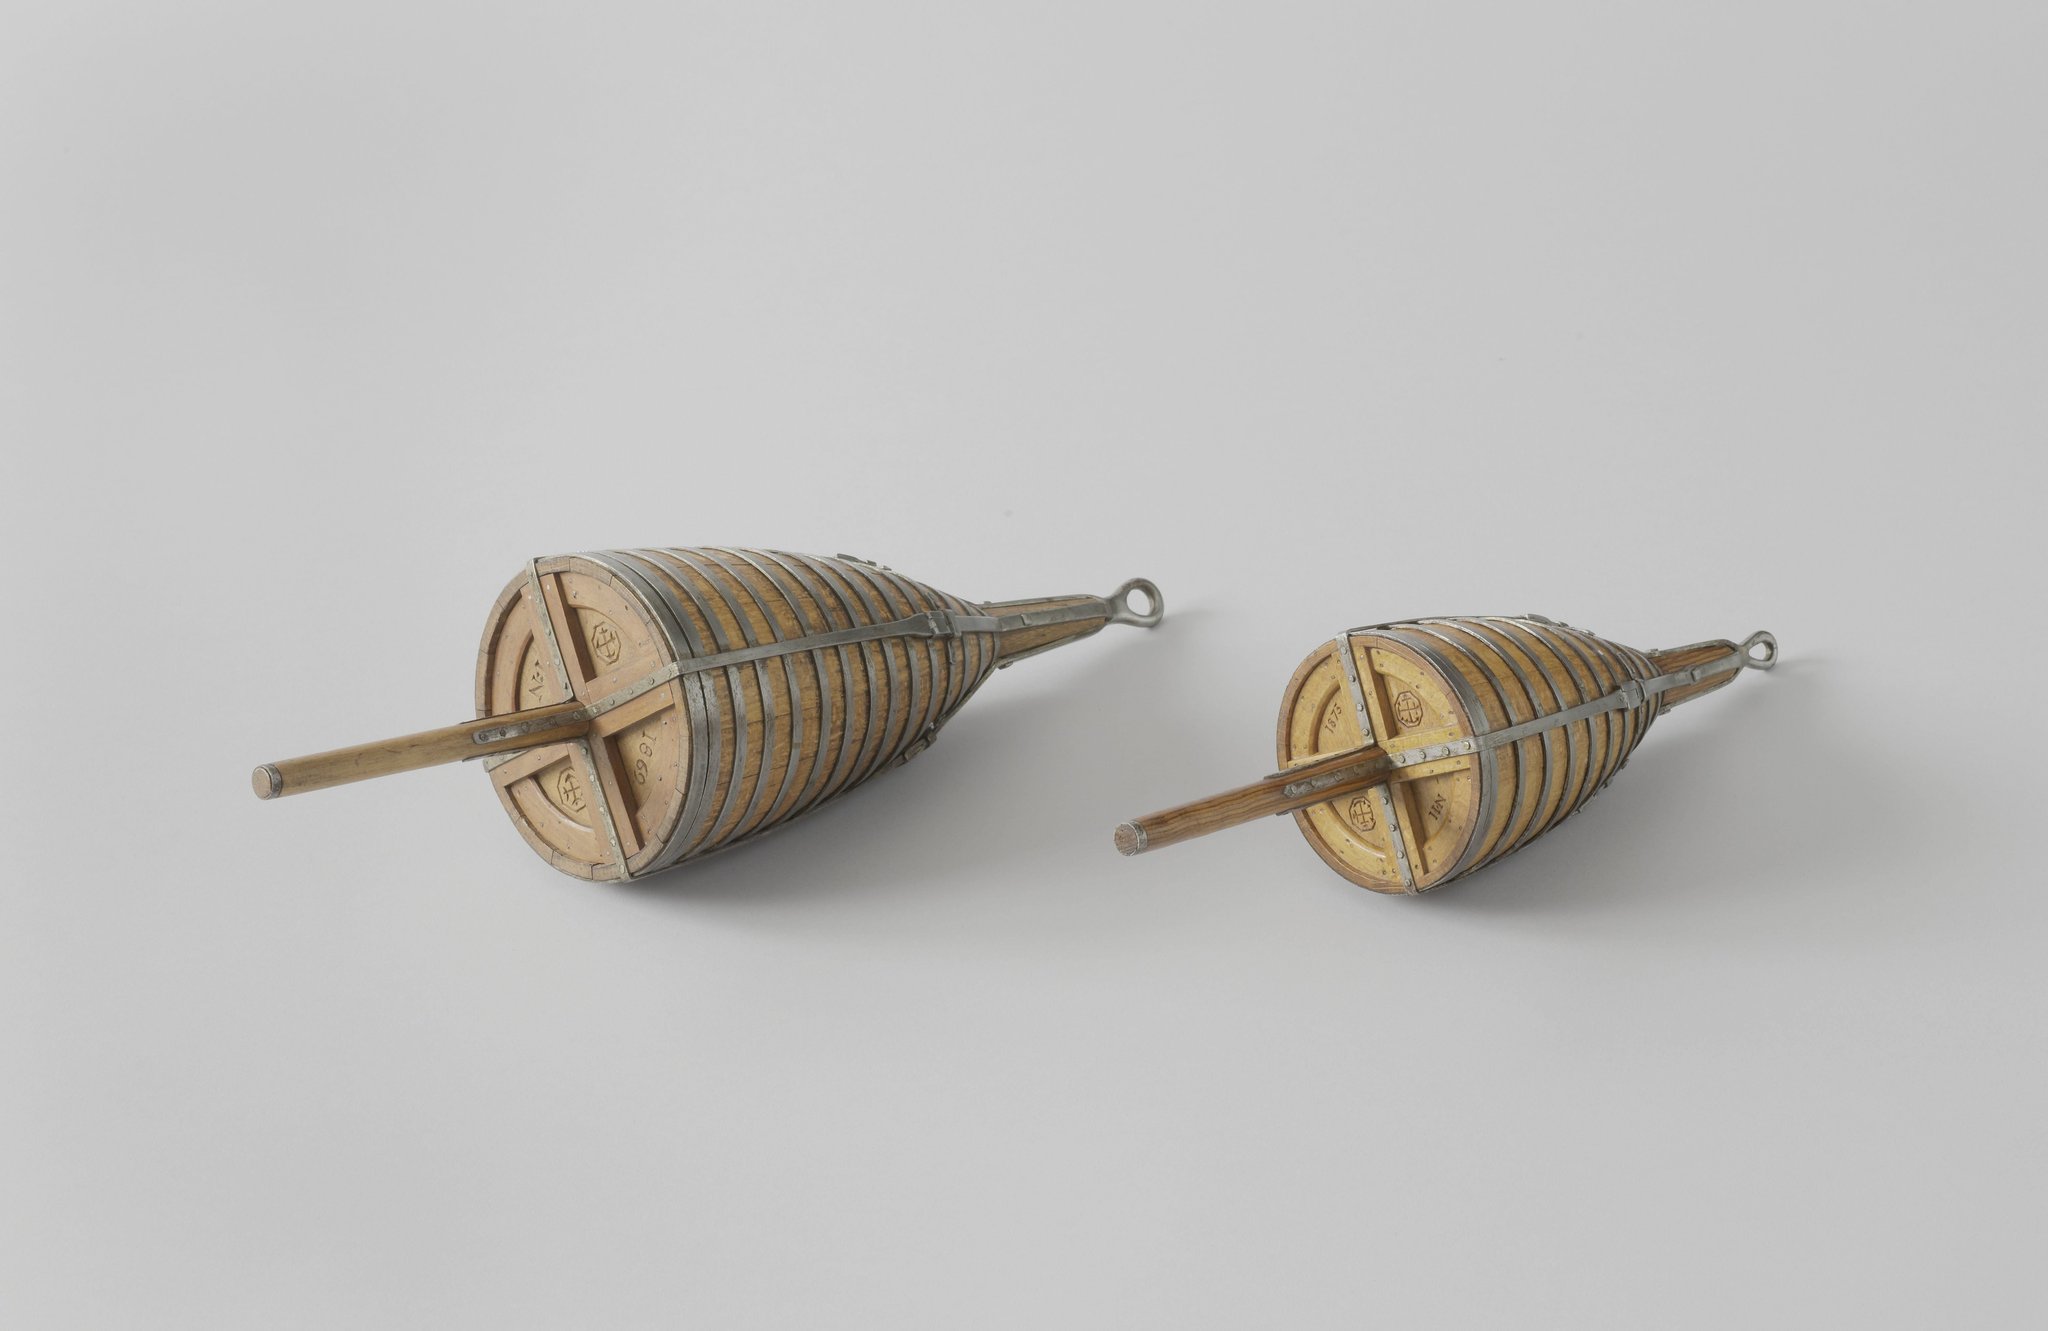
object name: demonstration model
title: Two Models of Buoys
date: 1873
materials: iron, wood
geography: enkhuizen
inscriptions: inscription, top centre: ‘N·II / 1873’, inscription, top centre: ‘N:I. / 1869’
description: Twee identieke modellen van een boei met een conisch lichaam met een scherp ondereind en platte ronde bovenkant, waar een paal uitsteekt. Zoals een vat is zij samengesteld uit duigen en hoepels. Onderaan aan een lange punt zit een oog voor de ankerketting. Gemerkt met gekruiste ankers. Schaal 1:10 (archief).